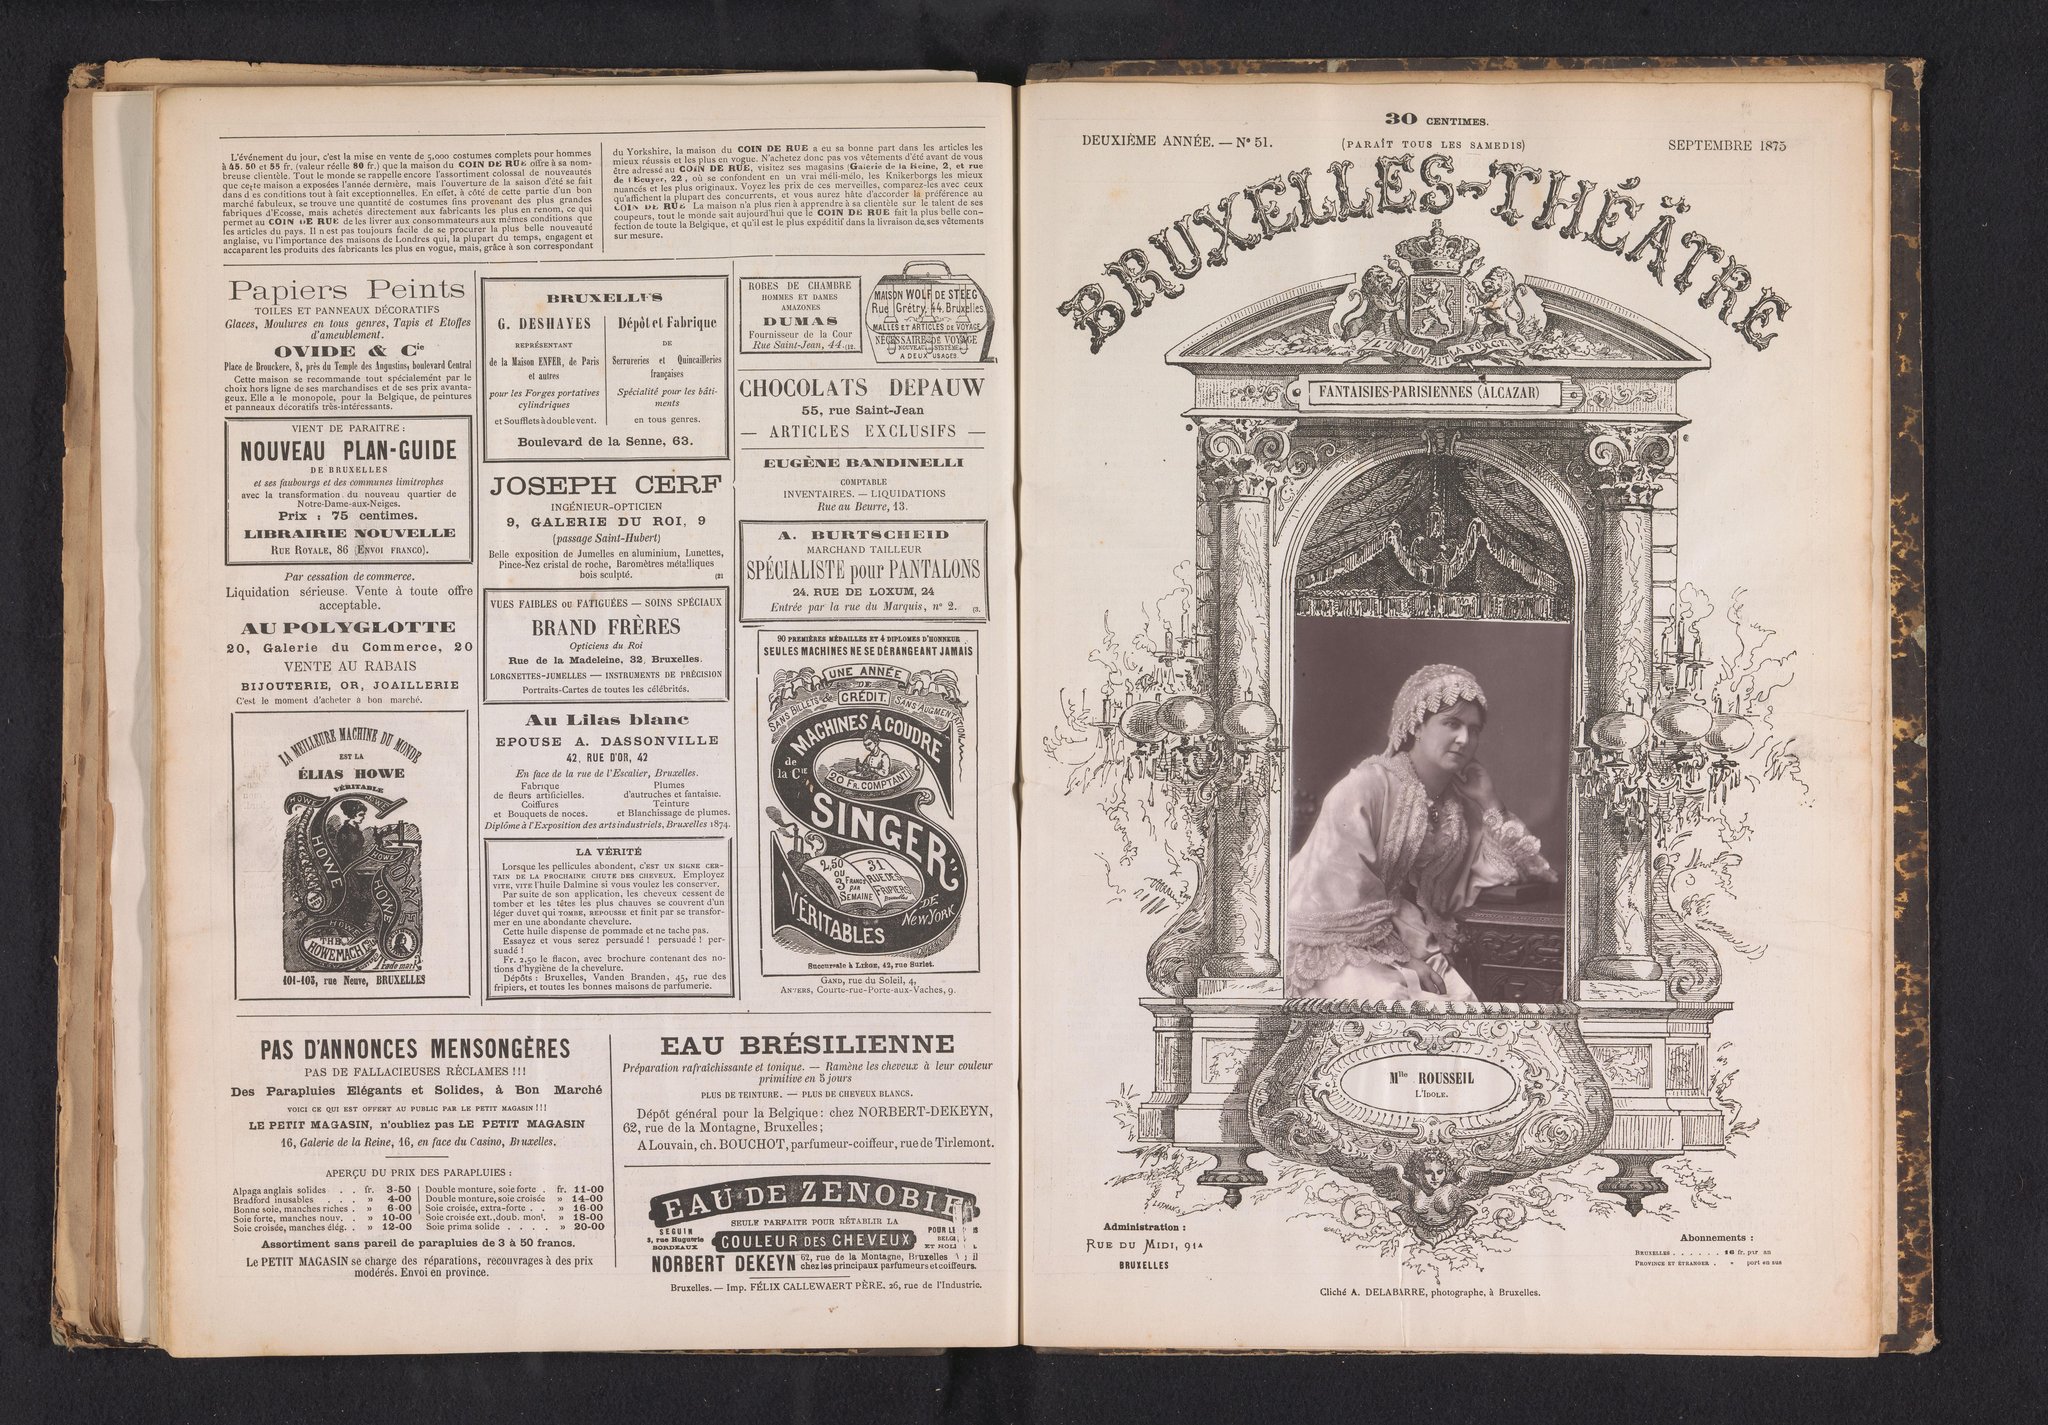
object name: page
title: Mlle Rousseil (L'idole)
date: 1870-1875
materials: paper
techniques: woodburytype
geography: brussels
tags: portrait of actor, actress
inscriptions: number: ‘No 51.’